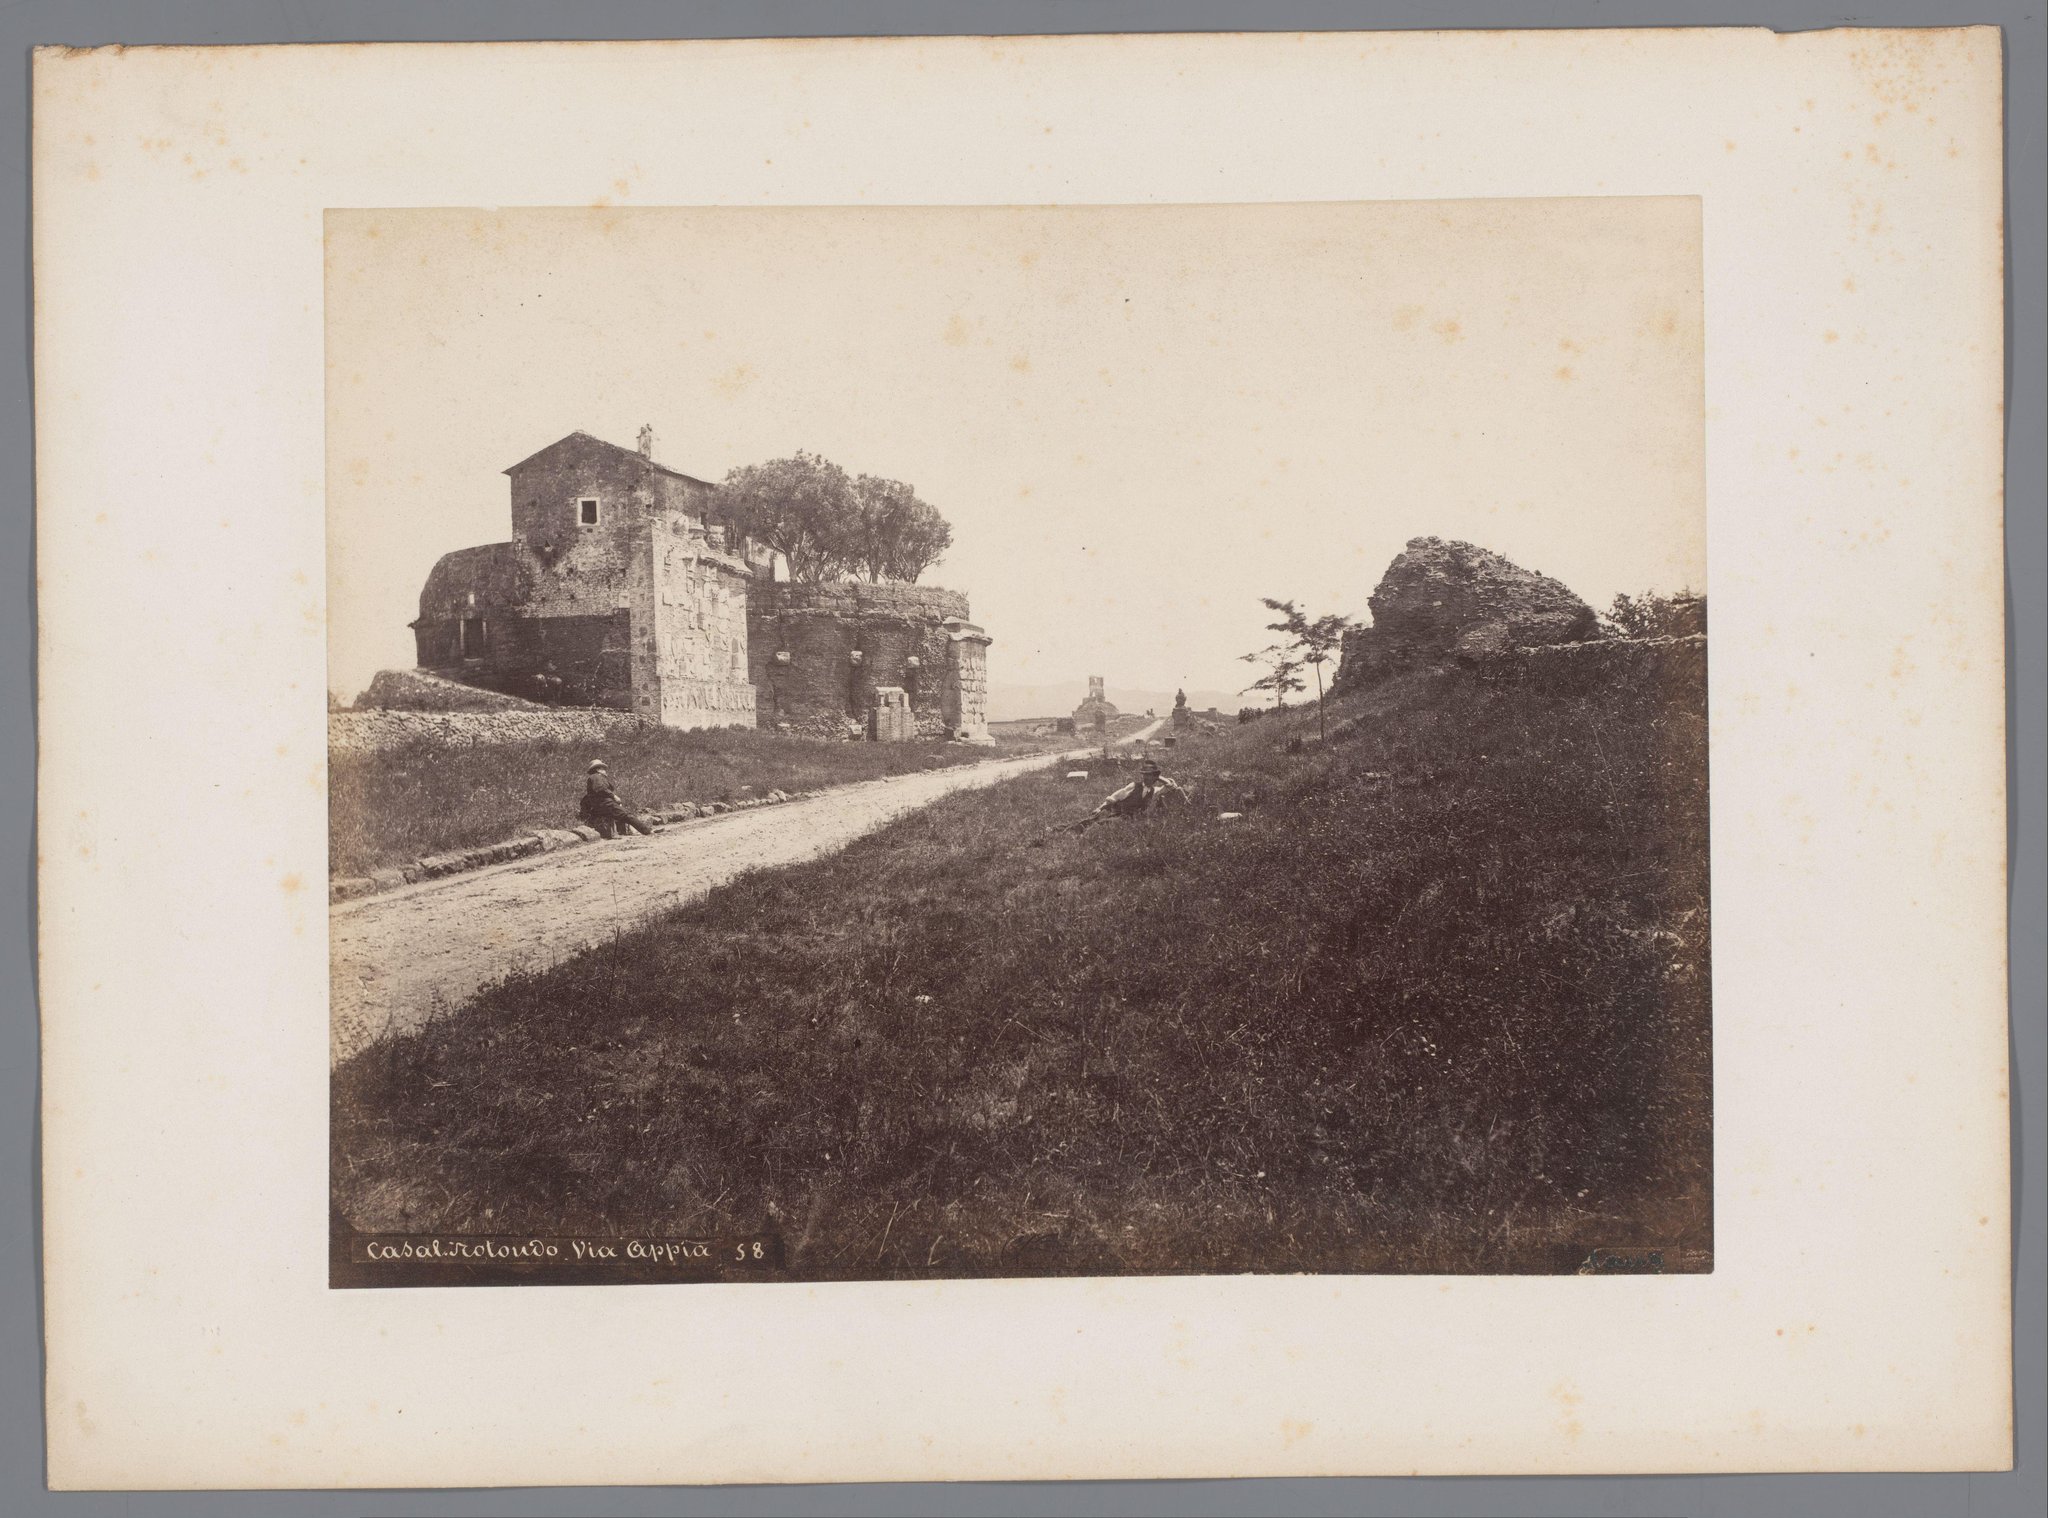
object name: photograph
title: Casal Rotondo Via Appia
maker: Anonymous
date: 1851-1900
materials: cardboard, paper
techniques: albumen print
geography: rome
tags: mausoleum, public road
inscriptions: number: ‘9’, number: ‘90’, number: ‘58’